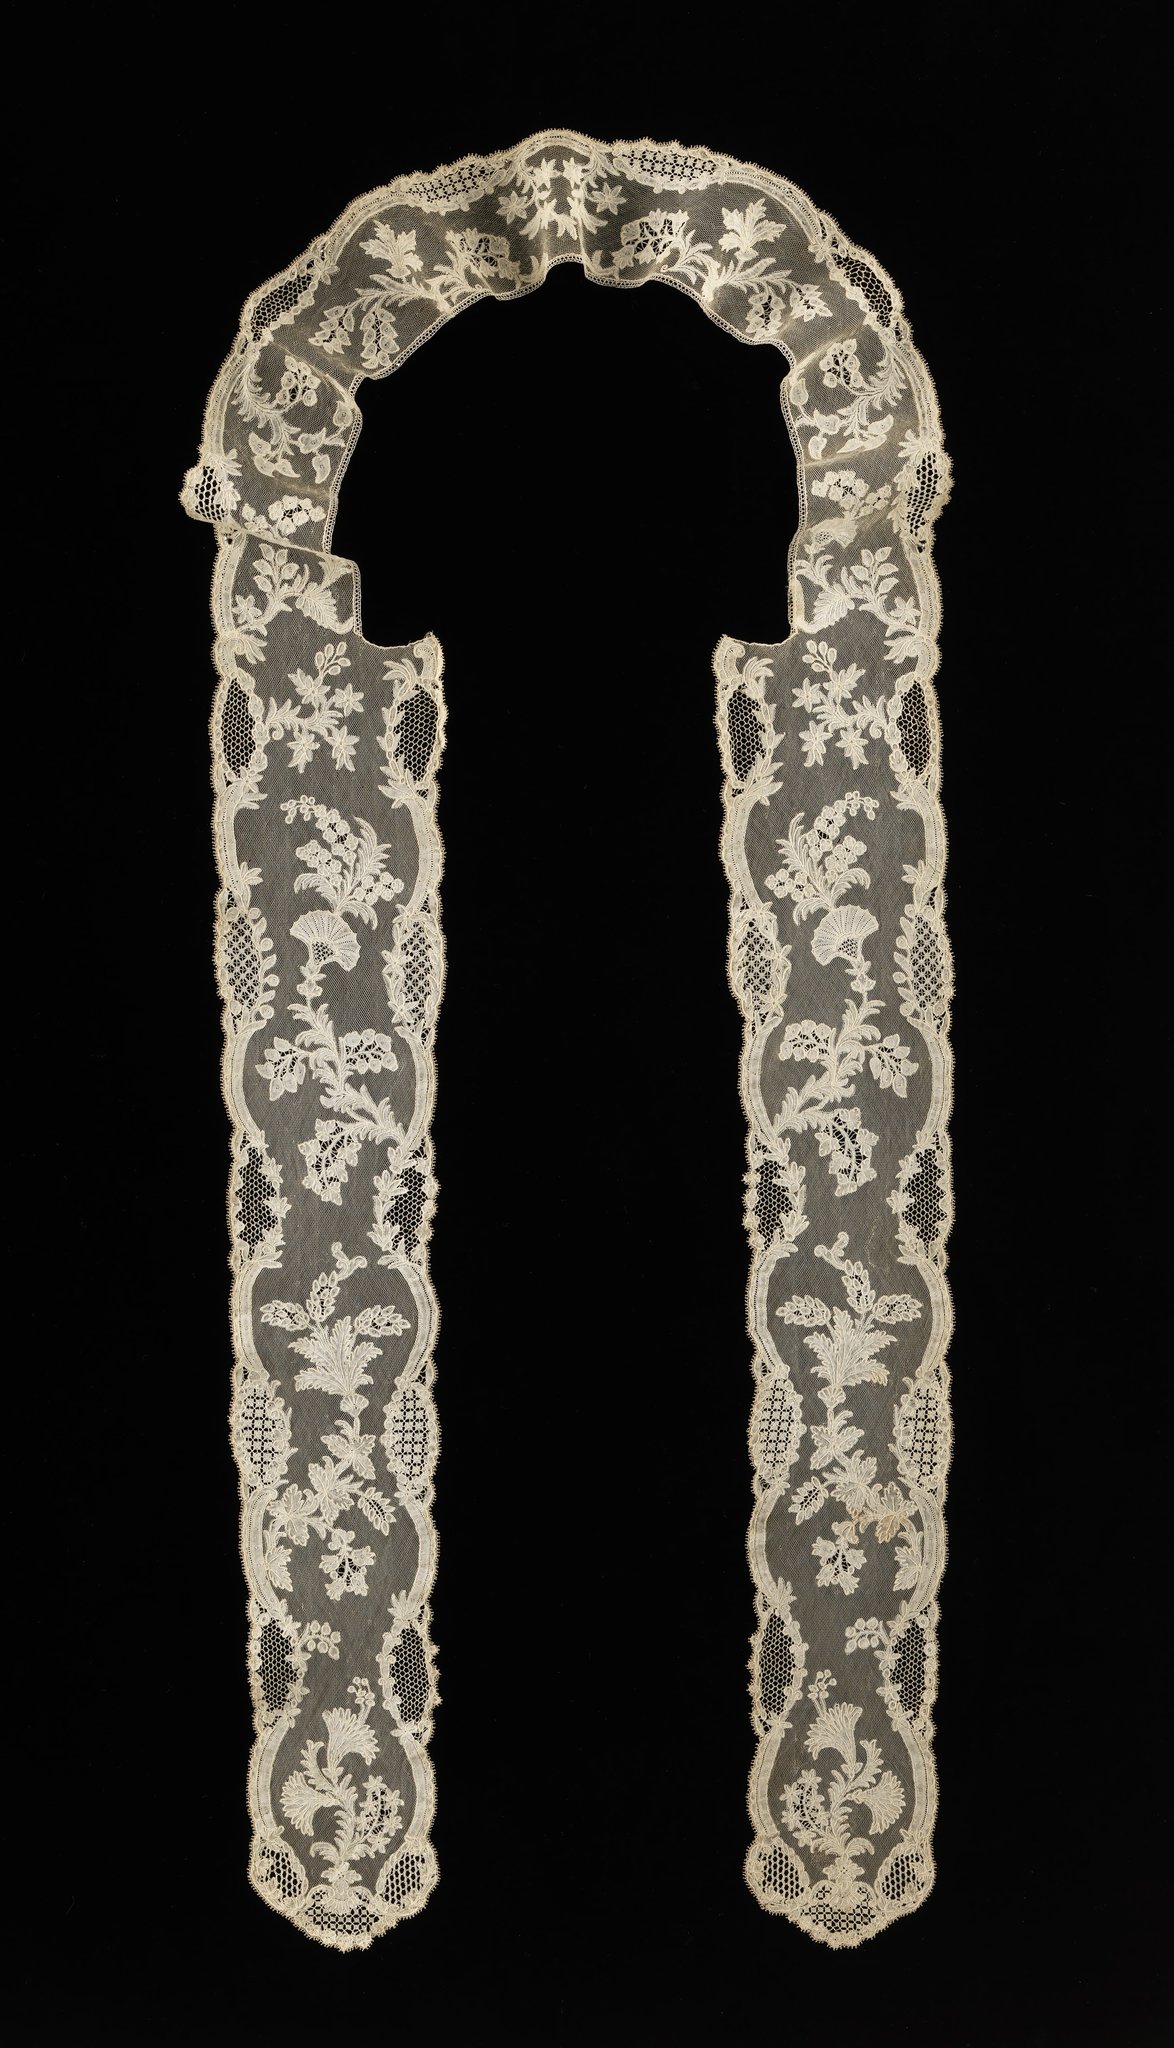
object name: lappet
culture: european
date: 1740-1770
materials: linen